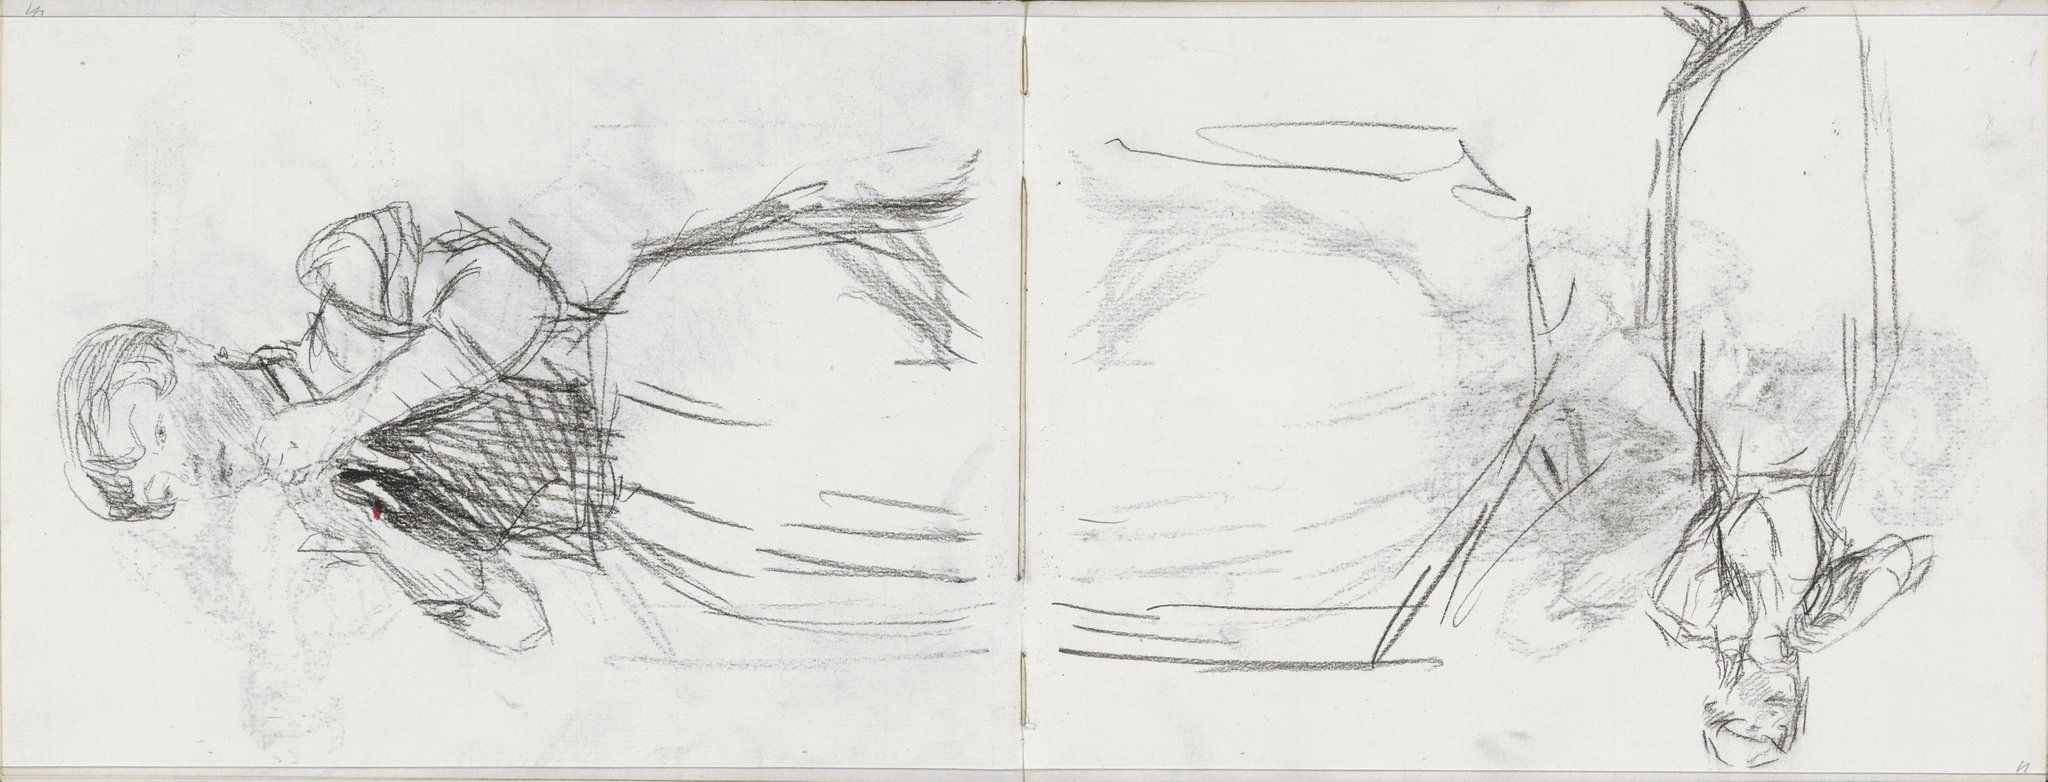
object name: sketchbook leaf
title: Studies van een staande vrouw met haar handen bij haar gezicht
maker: isaac israels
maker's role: draughtsman, painter, print maker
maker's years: 1865-1934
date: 1875-1934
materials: chalk, paper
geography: amsterdam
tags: adult woman (+ standing), hand(s) bent towards the head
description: Mogelijk knoopt ze een sjaaltje of hoofddoek. Blad 10 verso en blad 11 recto uit schetsboek XX met 26 bladen.